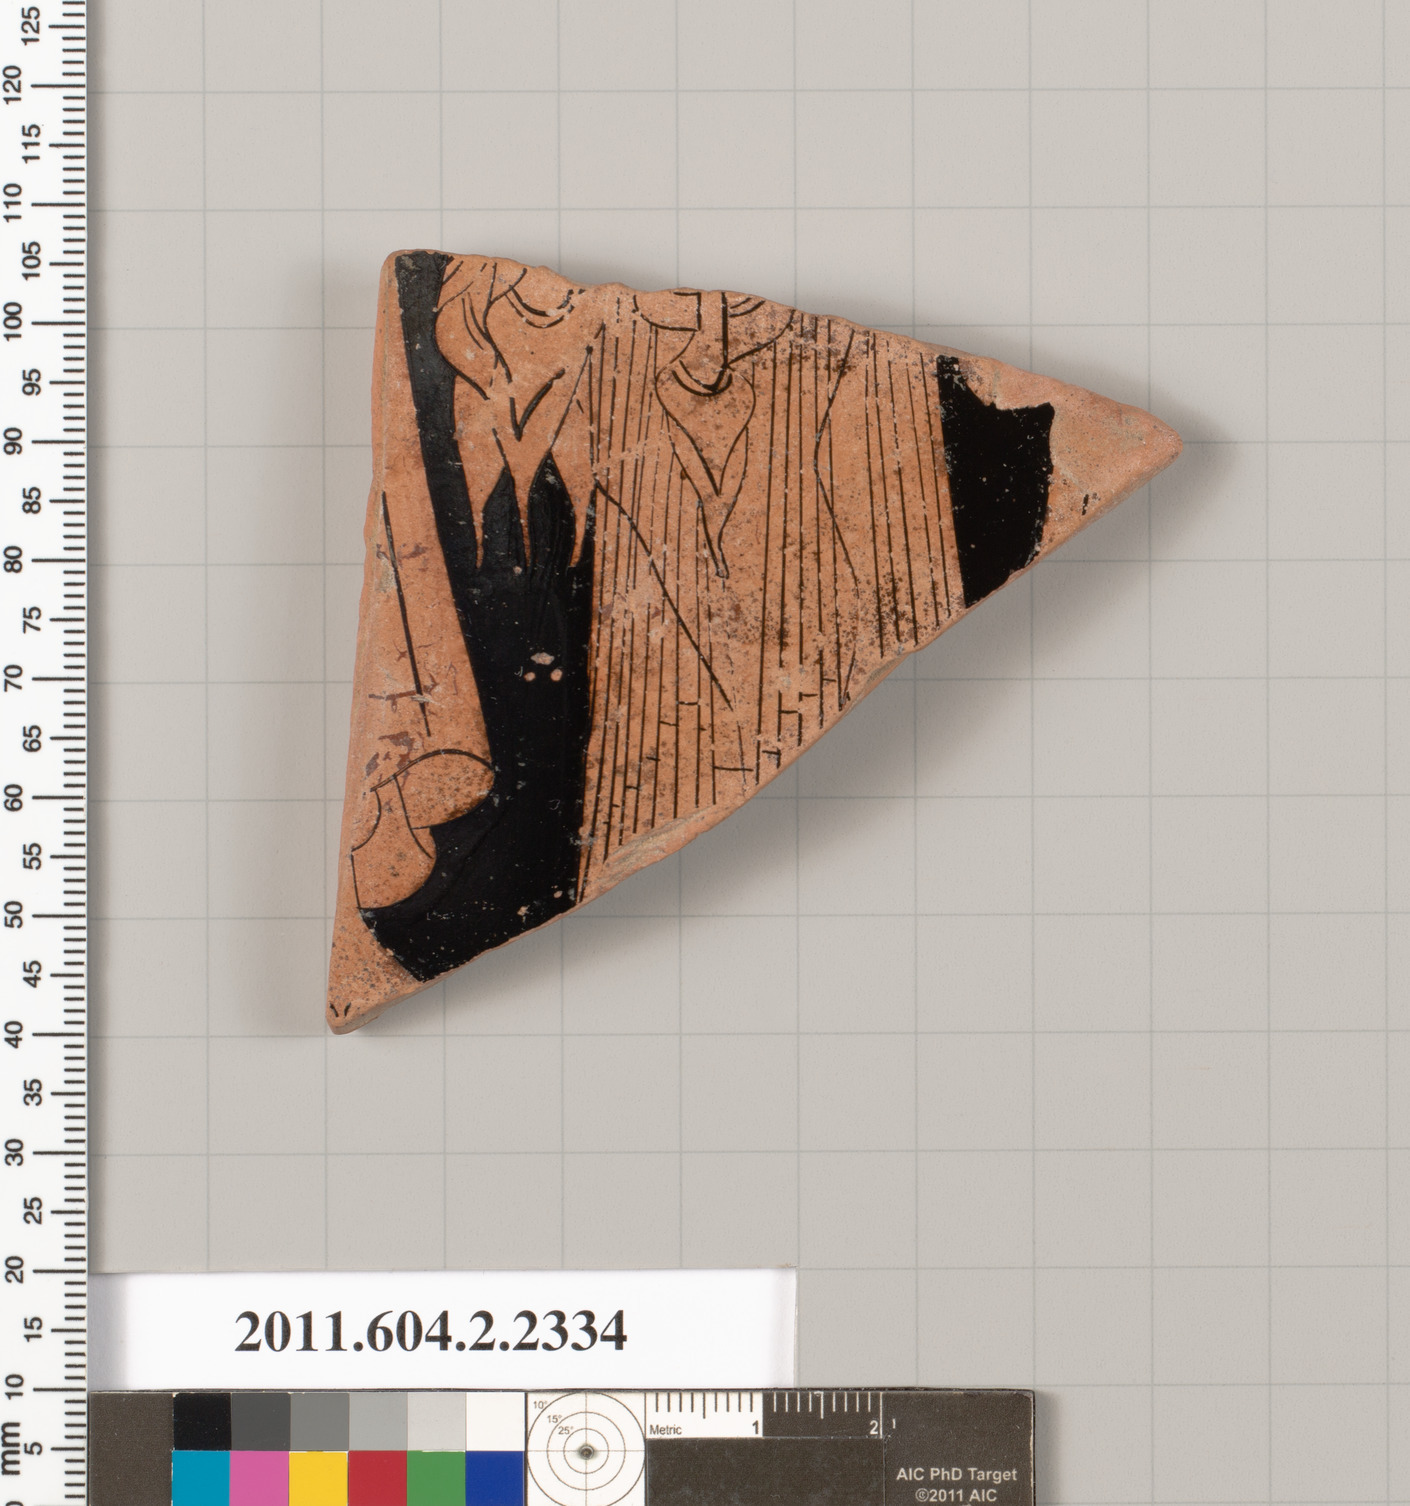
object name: skyphos fragment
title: Terracotta fragment of a skyphos (deep drinking cup)?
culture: archaic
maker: makron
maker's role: artist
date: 490-480 BCE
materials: terracotta